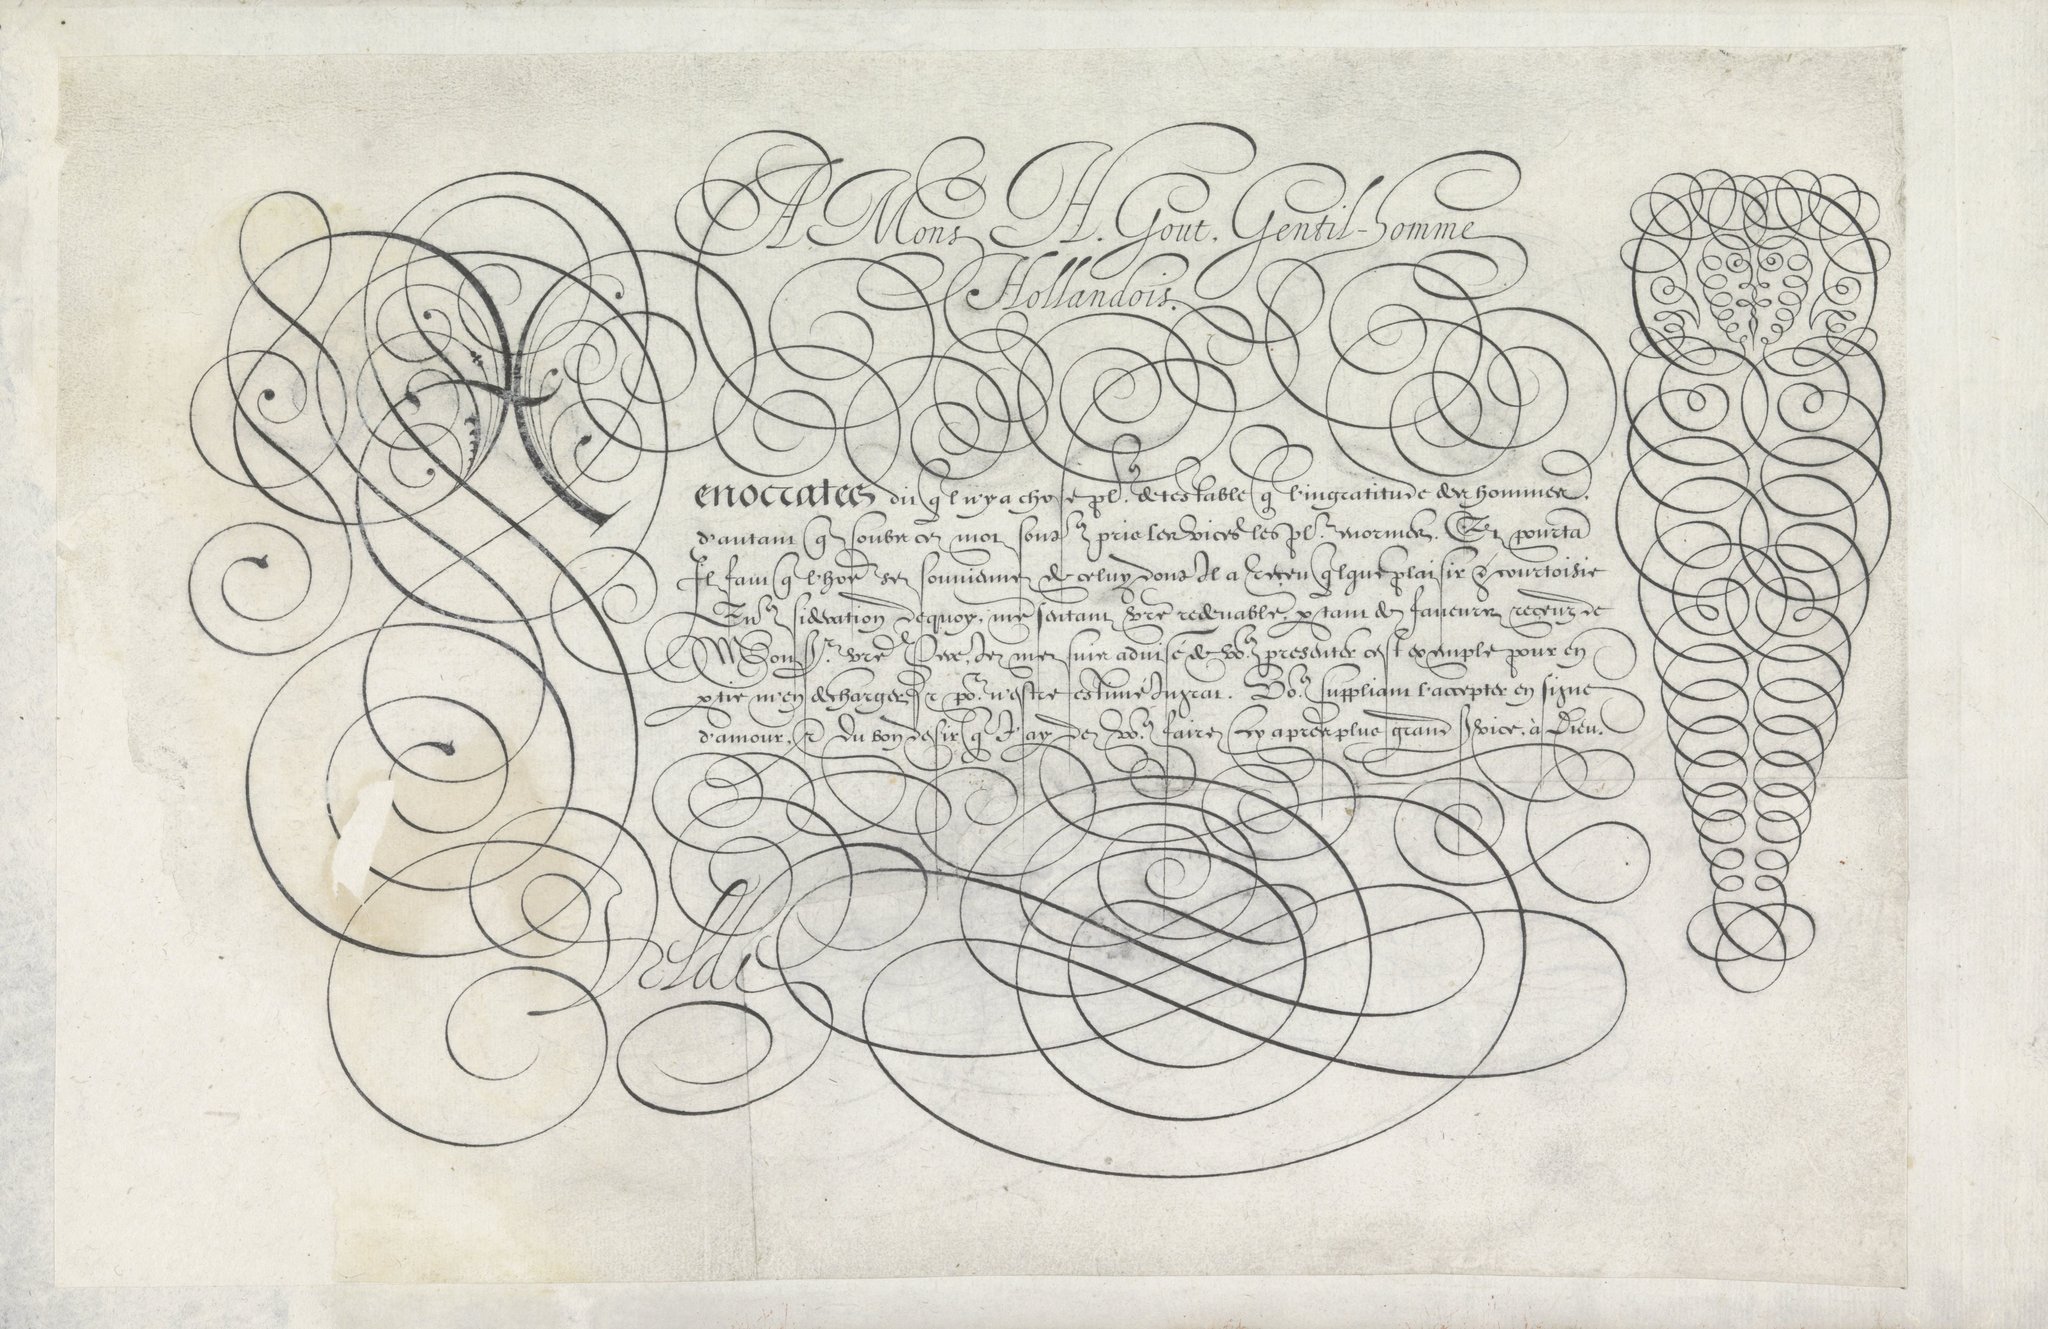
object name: drawing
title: Spieghel der schrijfkonste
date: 1605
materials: ink, paper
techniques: calligraphy, pen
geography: rotterdam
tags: calligraphy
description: Kalligrafische tekening met de aanhef: A mons H. Gout gentil-homme Hollandois. Daaronder in een andere letter een initiaal X en zeven regels tekst in het Frans: Xenocrates dit q(ui)l n'y a ... De tekst is omlijst door krulwerk. De tekening maakt deel uit van een album.